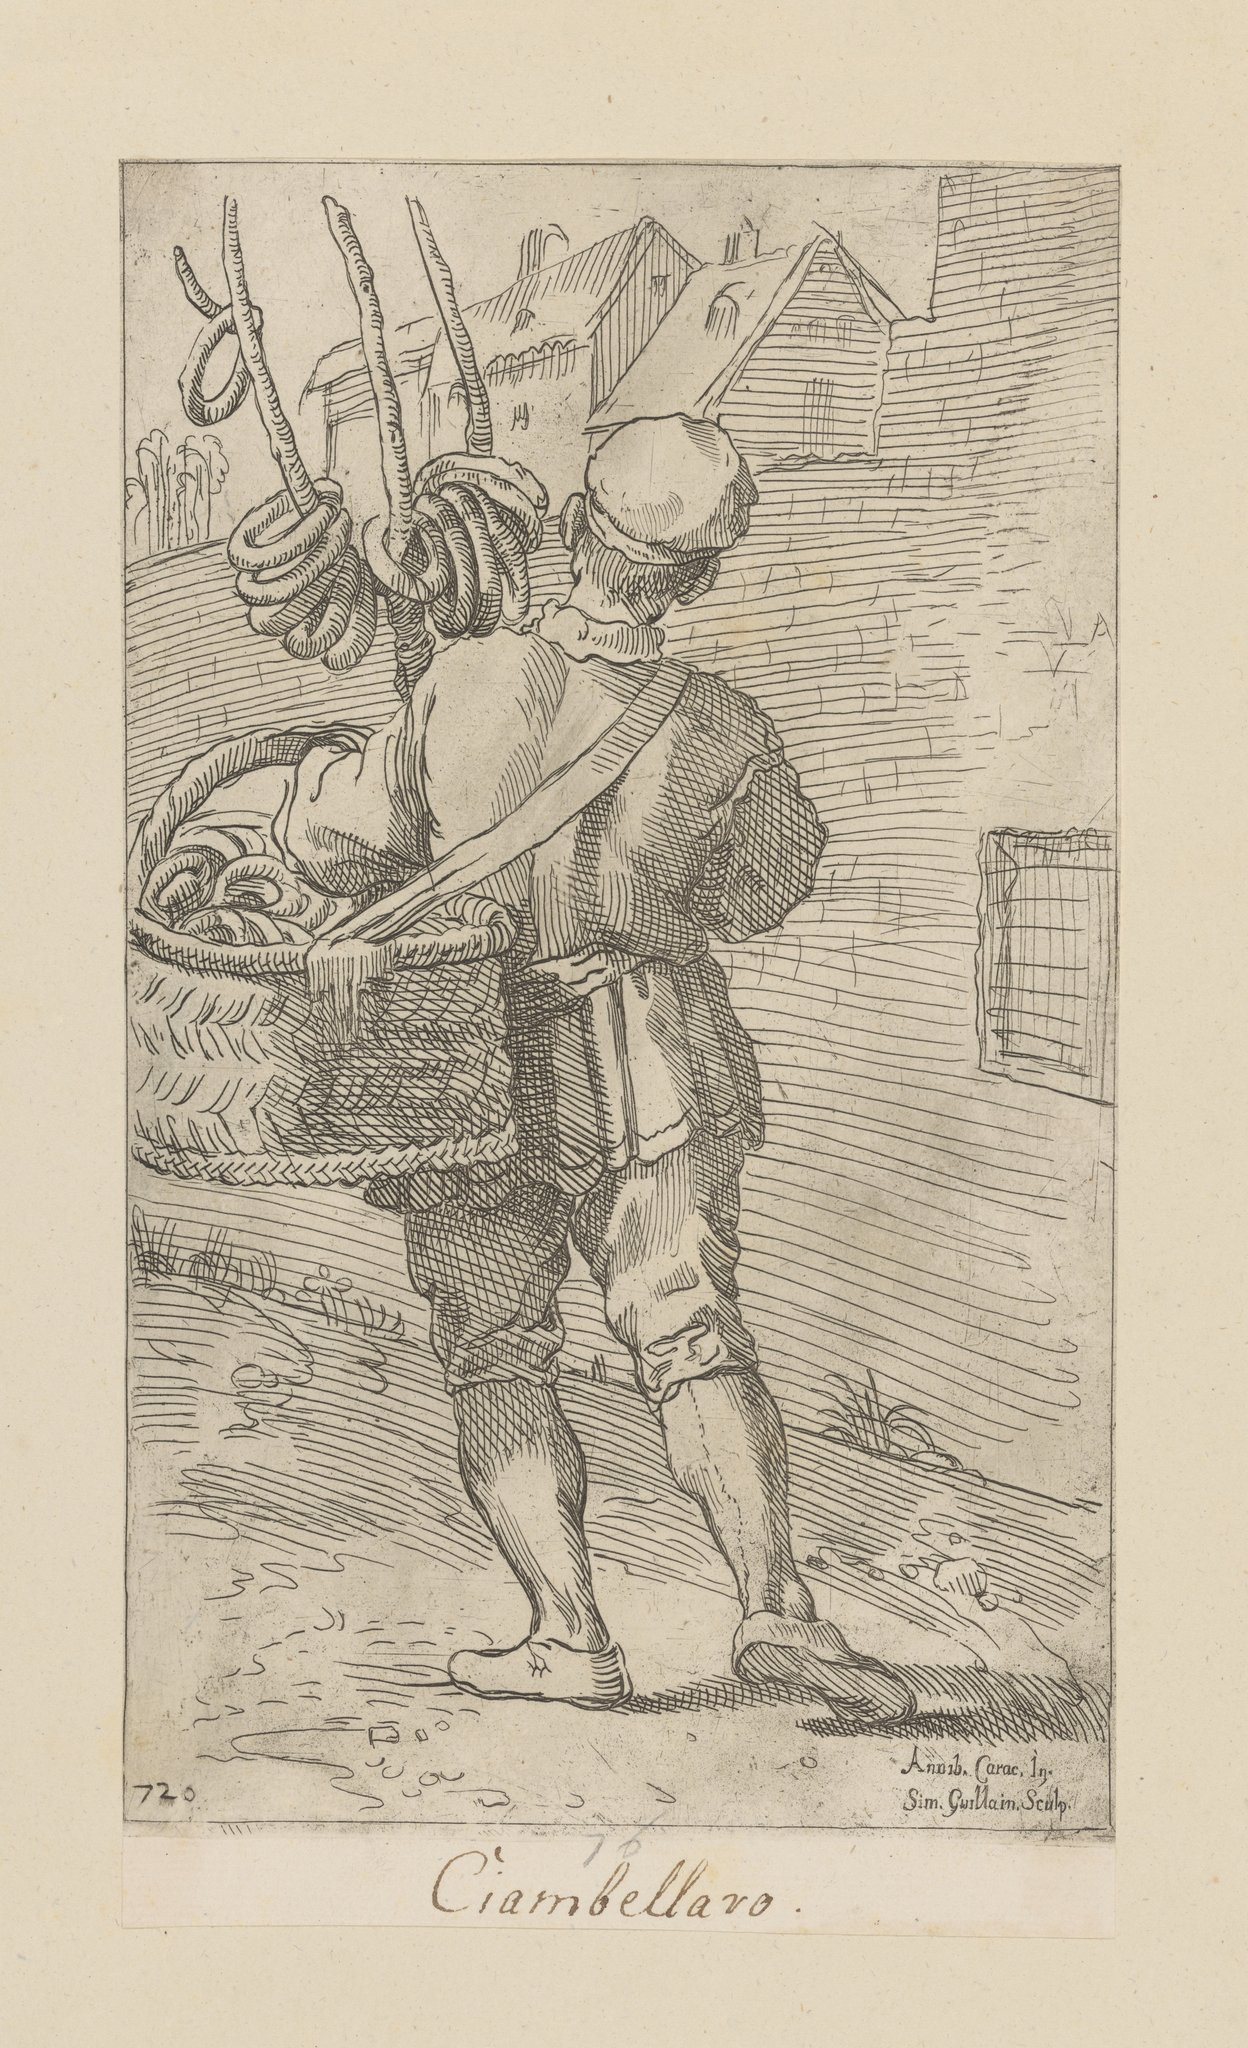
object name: print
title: Plate 72: Donut vendor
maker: simon guillain ii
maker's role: artist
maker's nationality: french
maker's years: 1618-1718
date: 1646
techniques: etching